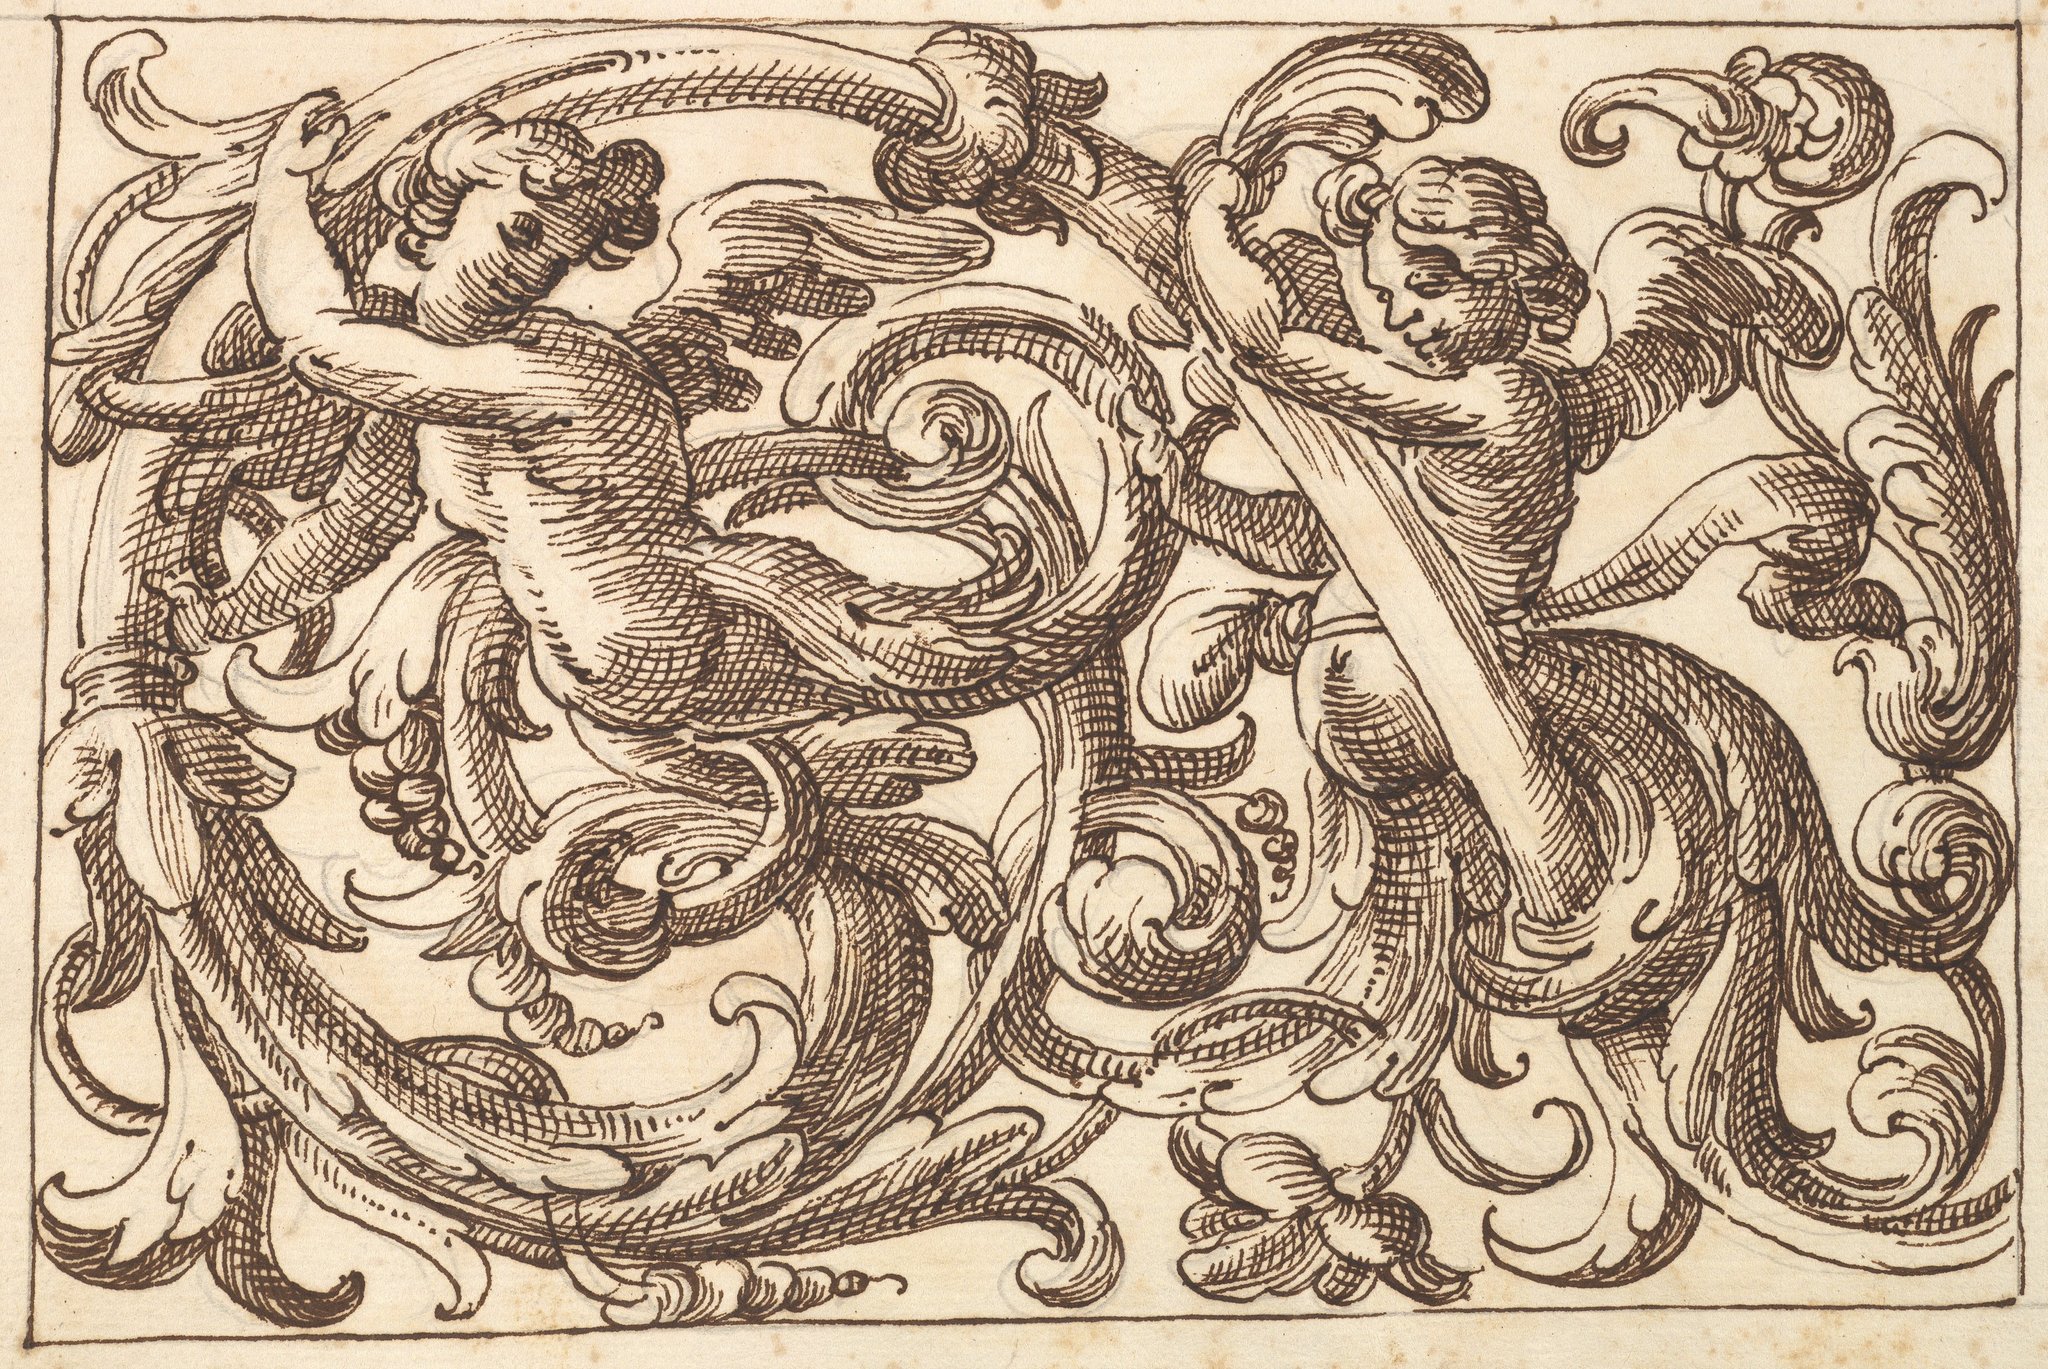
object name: collection ornament architecture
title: Horizontal Panel Design with Two Young Male Figures Interspersed between Acanthus Rinceaux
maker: anonymous, italian, venetian, 17th century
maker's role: artist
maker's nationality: italian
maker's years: 1600-1700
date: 1601-1700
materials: ink, drawing material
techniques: pen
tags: men,acanthus